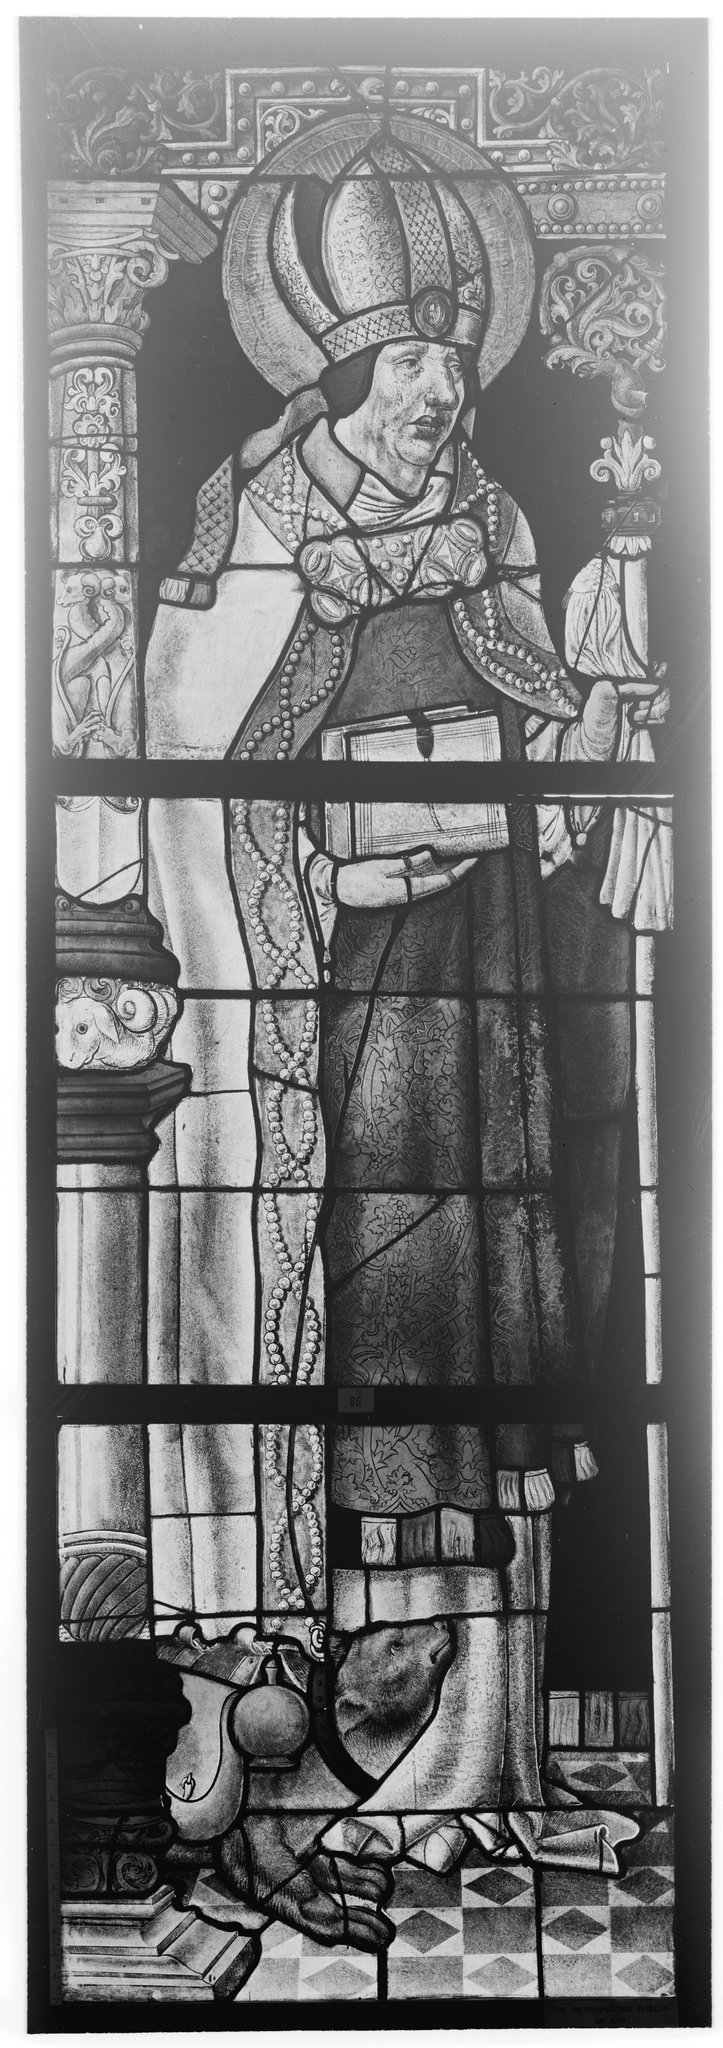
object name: panel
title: Saint Maximin, Bishop of Trèves, with a bear (one of a pair)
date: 1510-1530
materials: glass, metal, paint, pigment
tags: bishops,saints